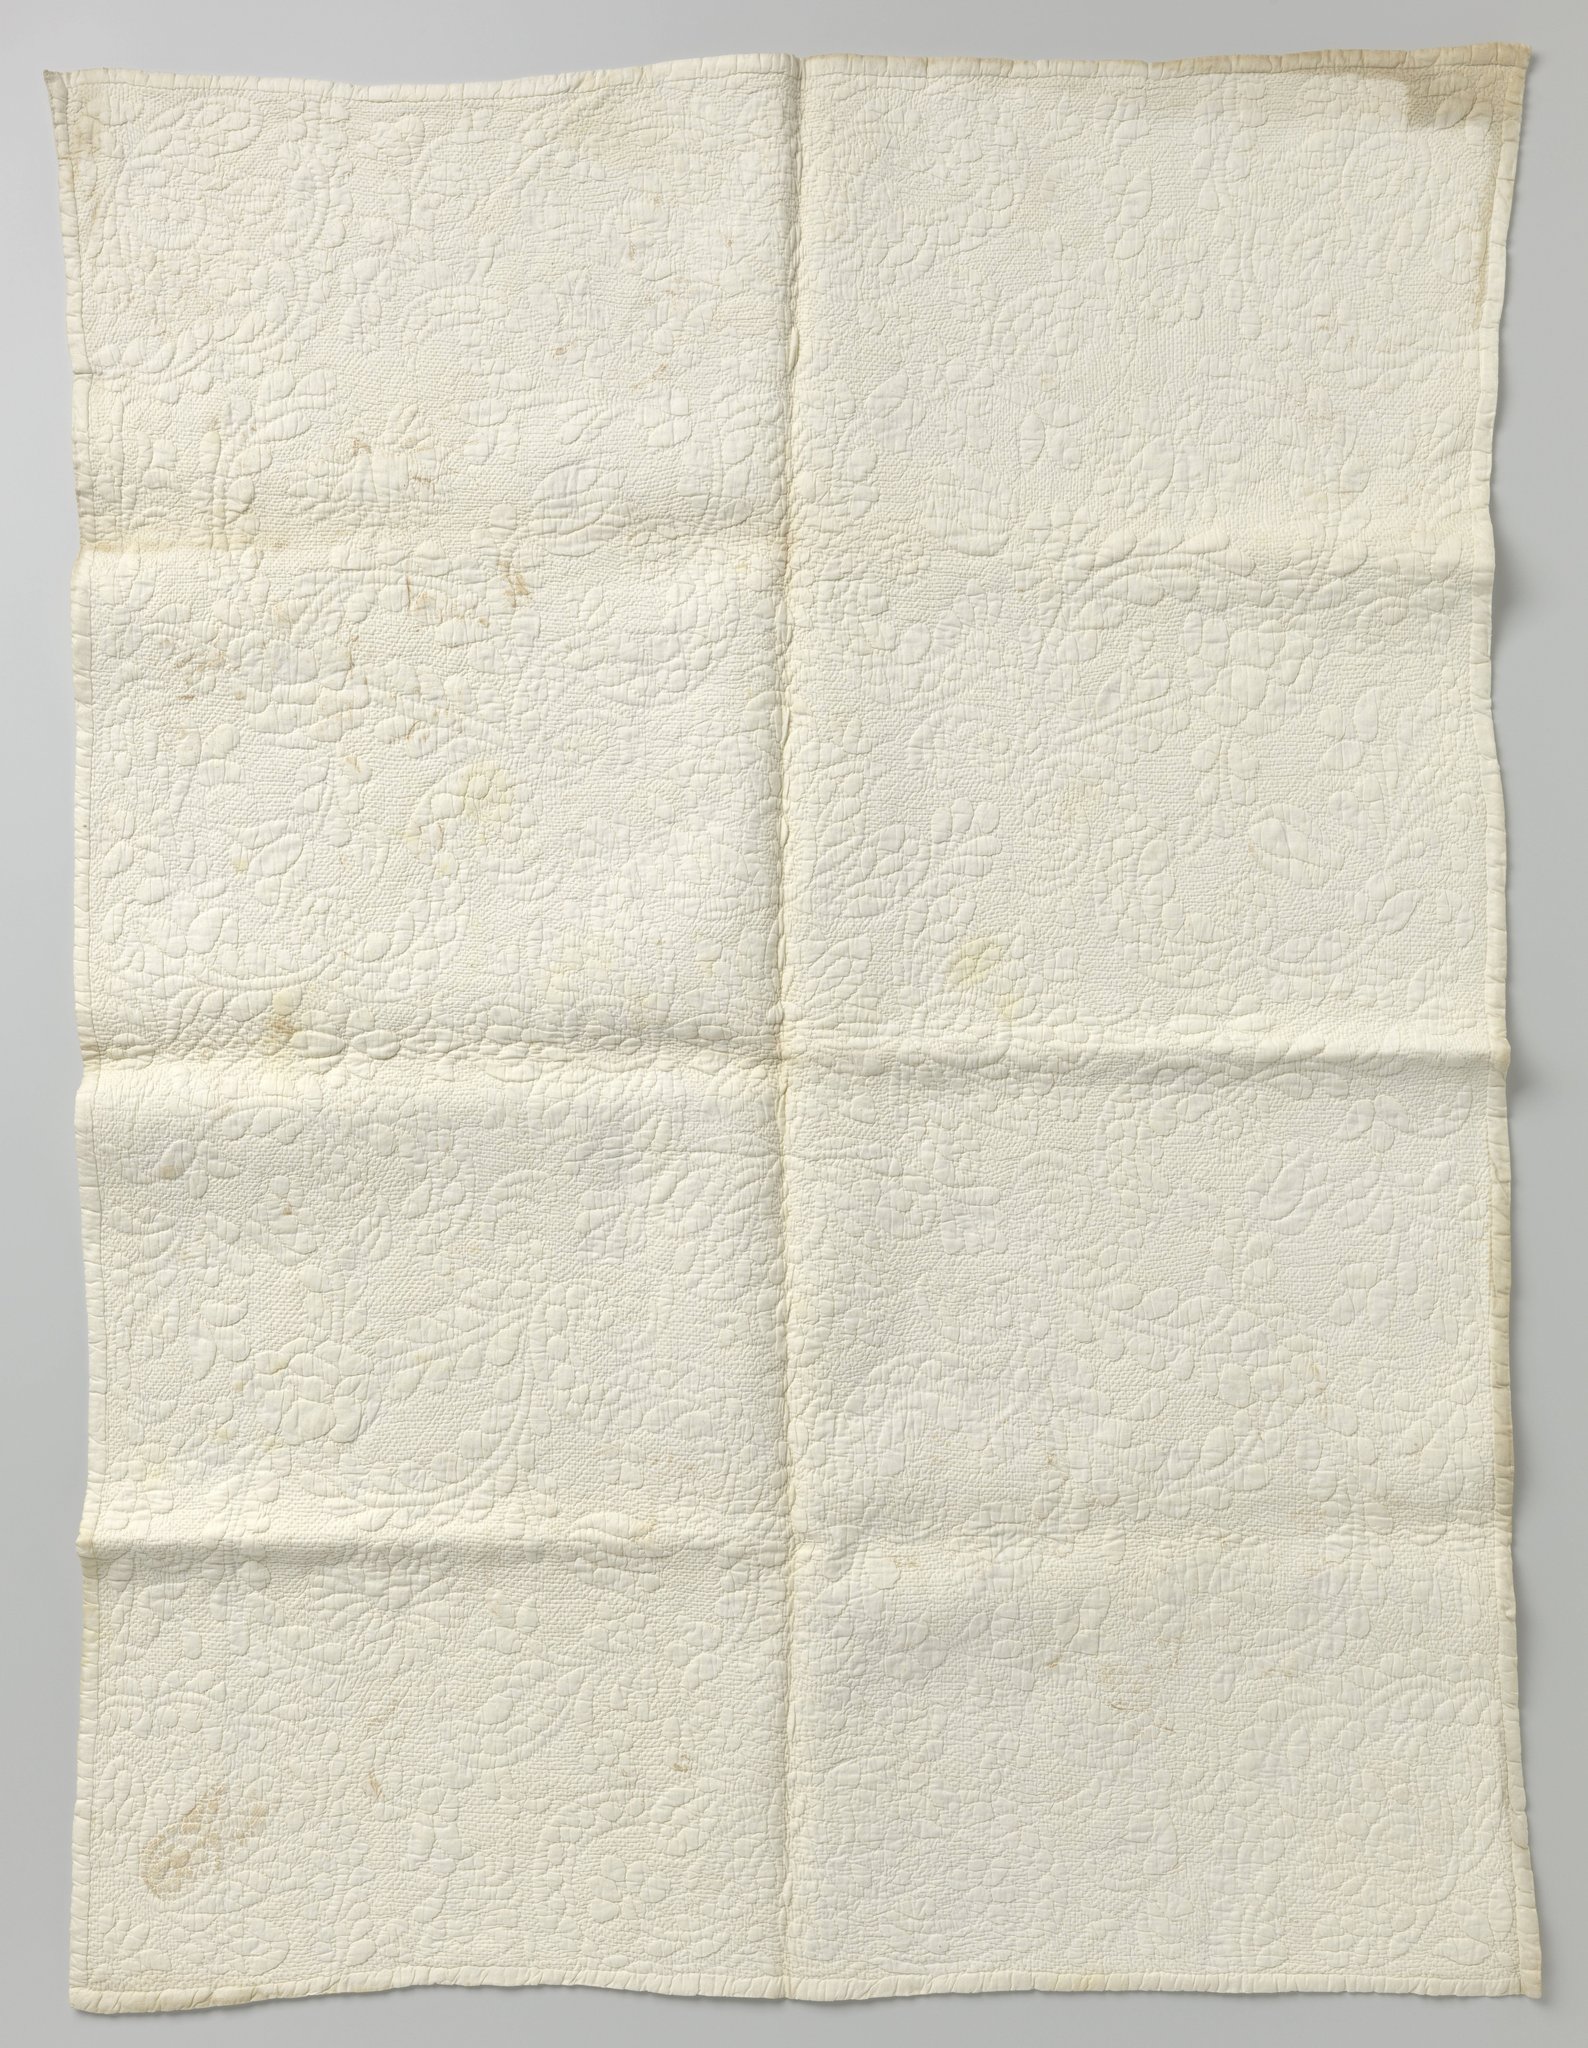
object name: bedspread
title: Kindersprei van doorgestikte katoen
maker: Anonymous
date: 1700-1799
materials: cotton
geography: northern netherlands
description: Kindersprei van doorgestikte witte katoen met een patroon van voluten en tulpen.